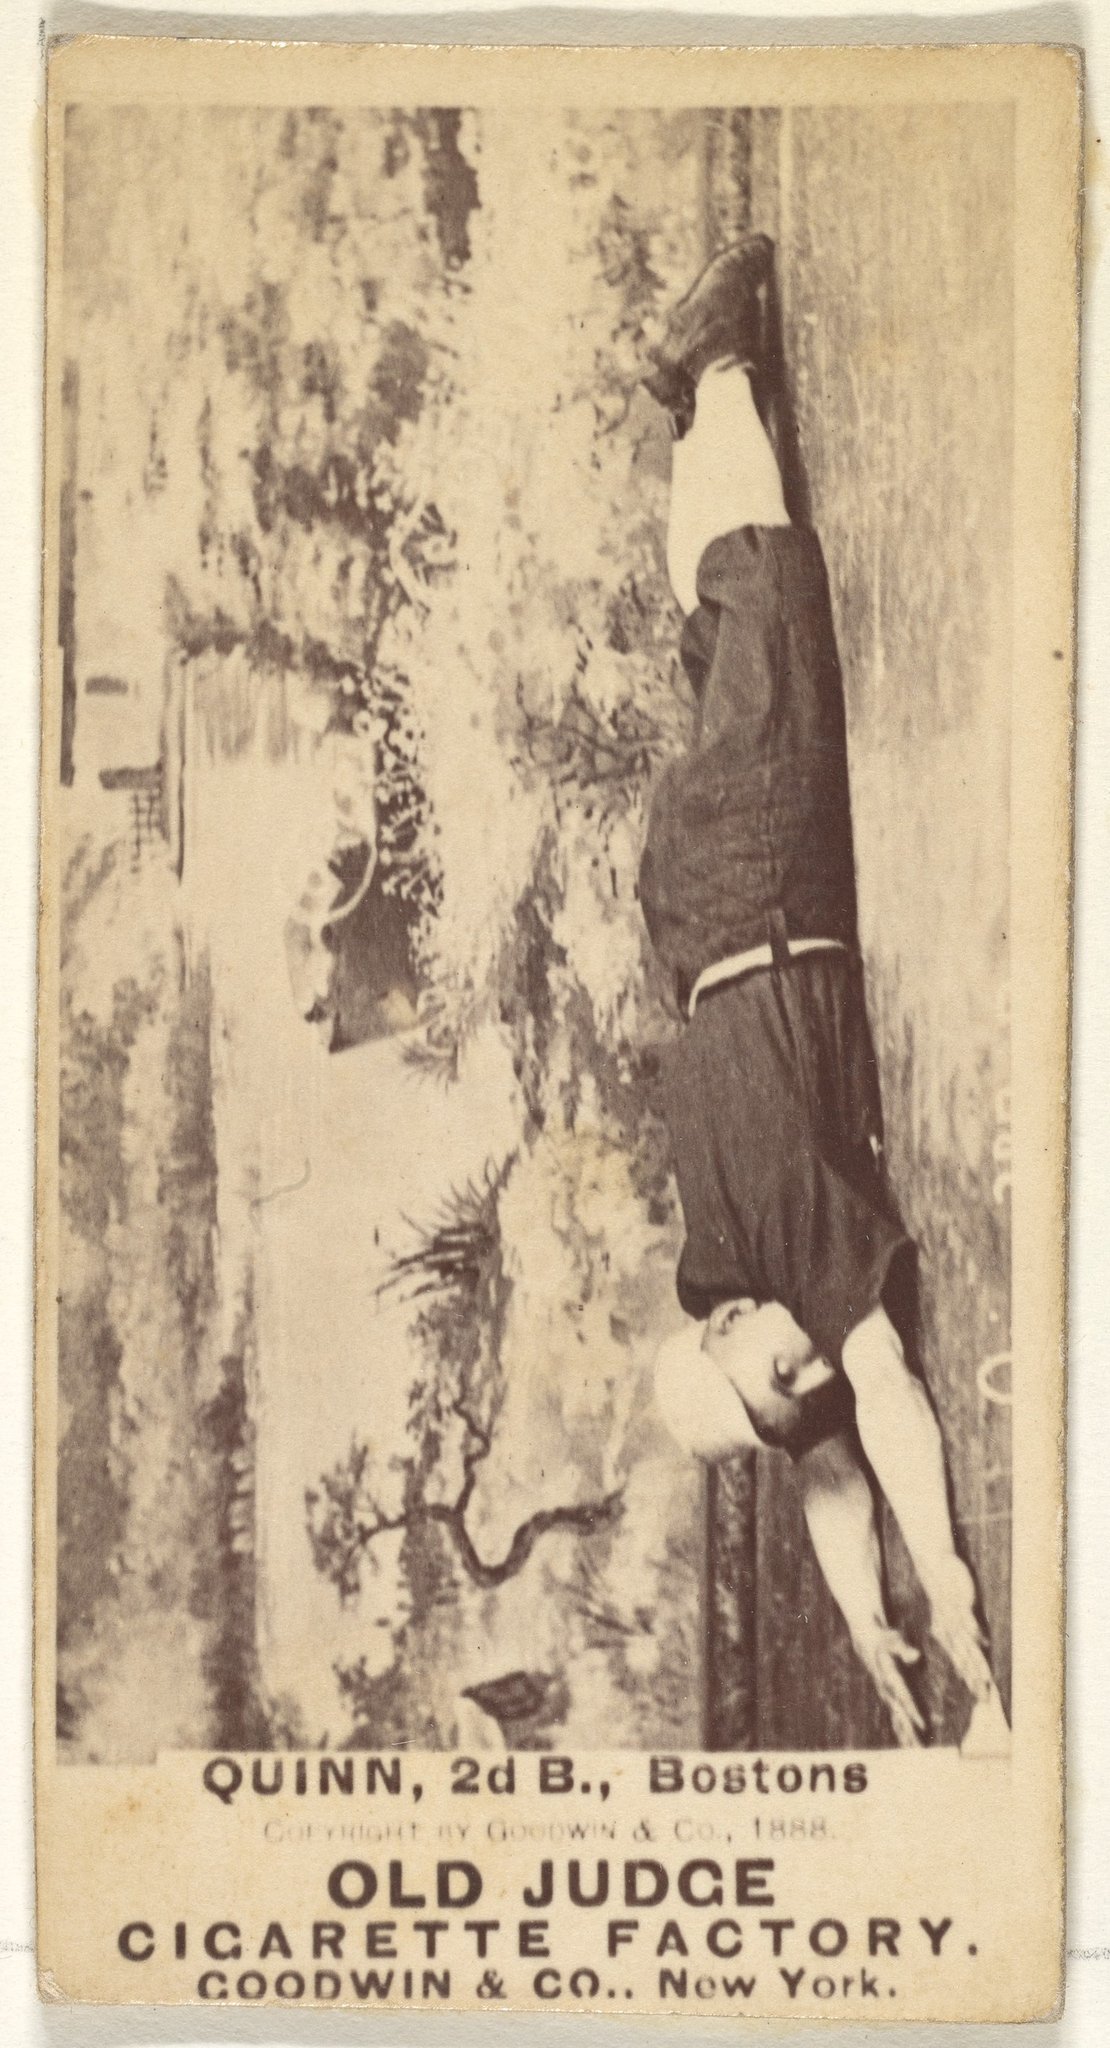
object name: baseball card, photograph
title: Quinn, 2nd Base, Boston, from the Old Judge series (N172) for Old Judge Cigarettes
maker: goodwin & company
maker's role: publisher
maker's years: 1850-1950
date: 1888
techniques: albumen silver print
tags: men,portraits,baseball,athletes